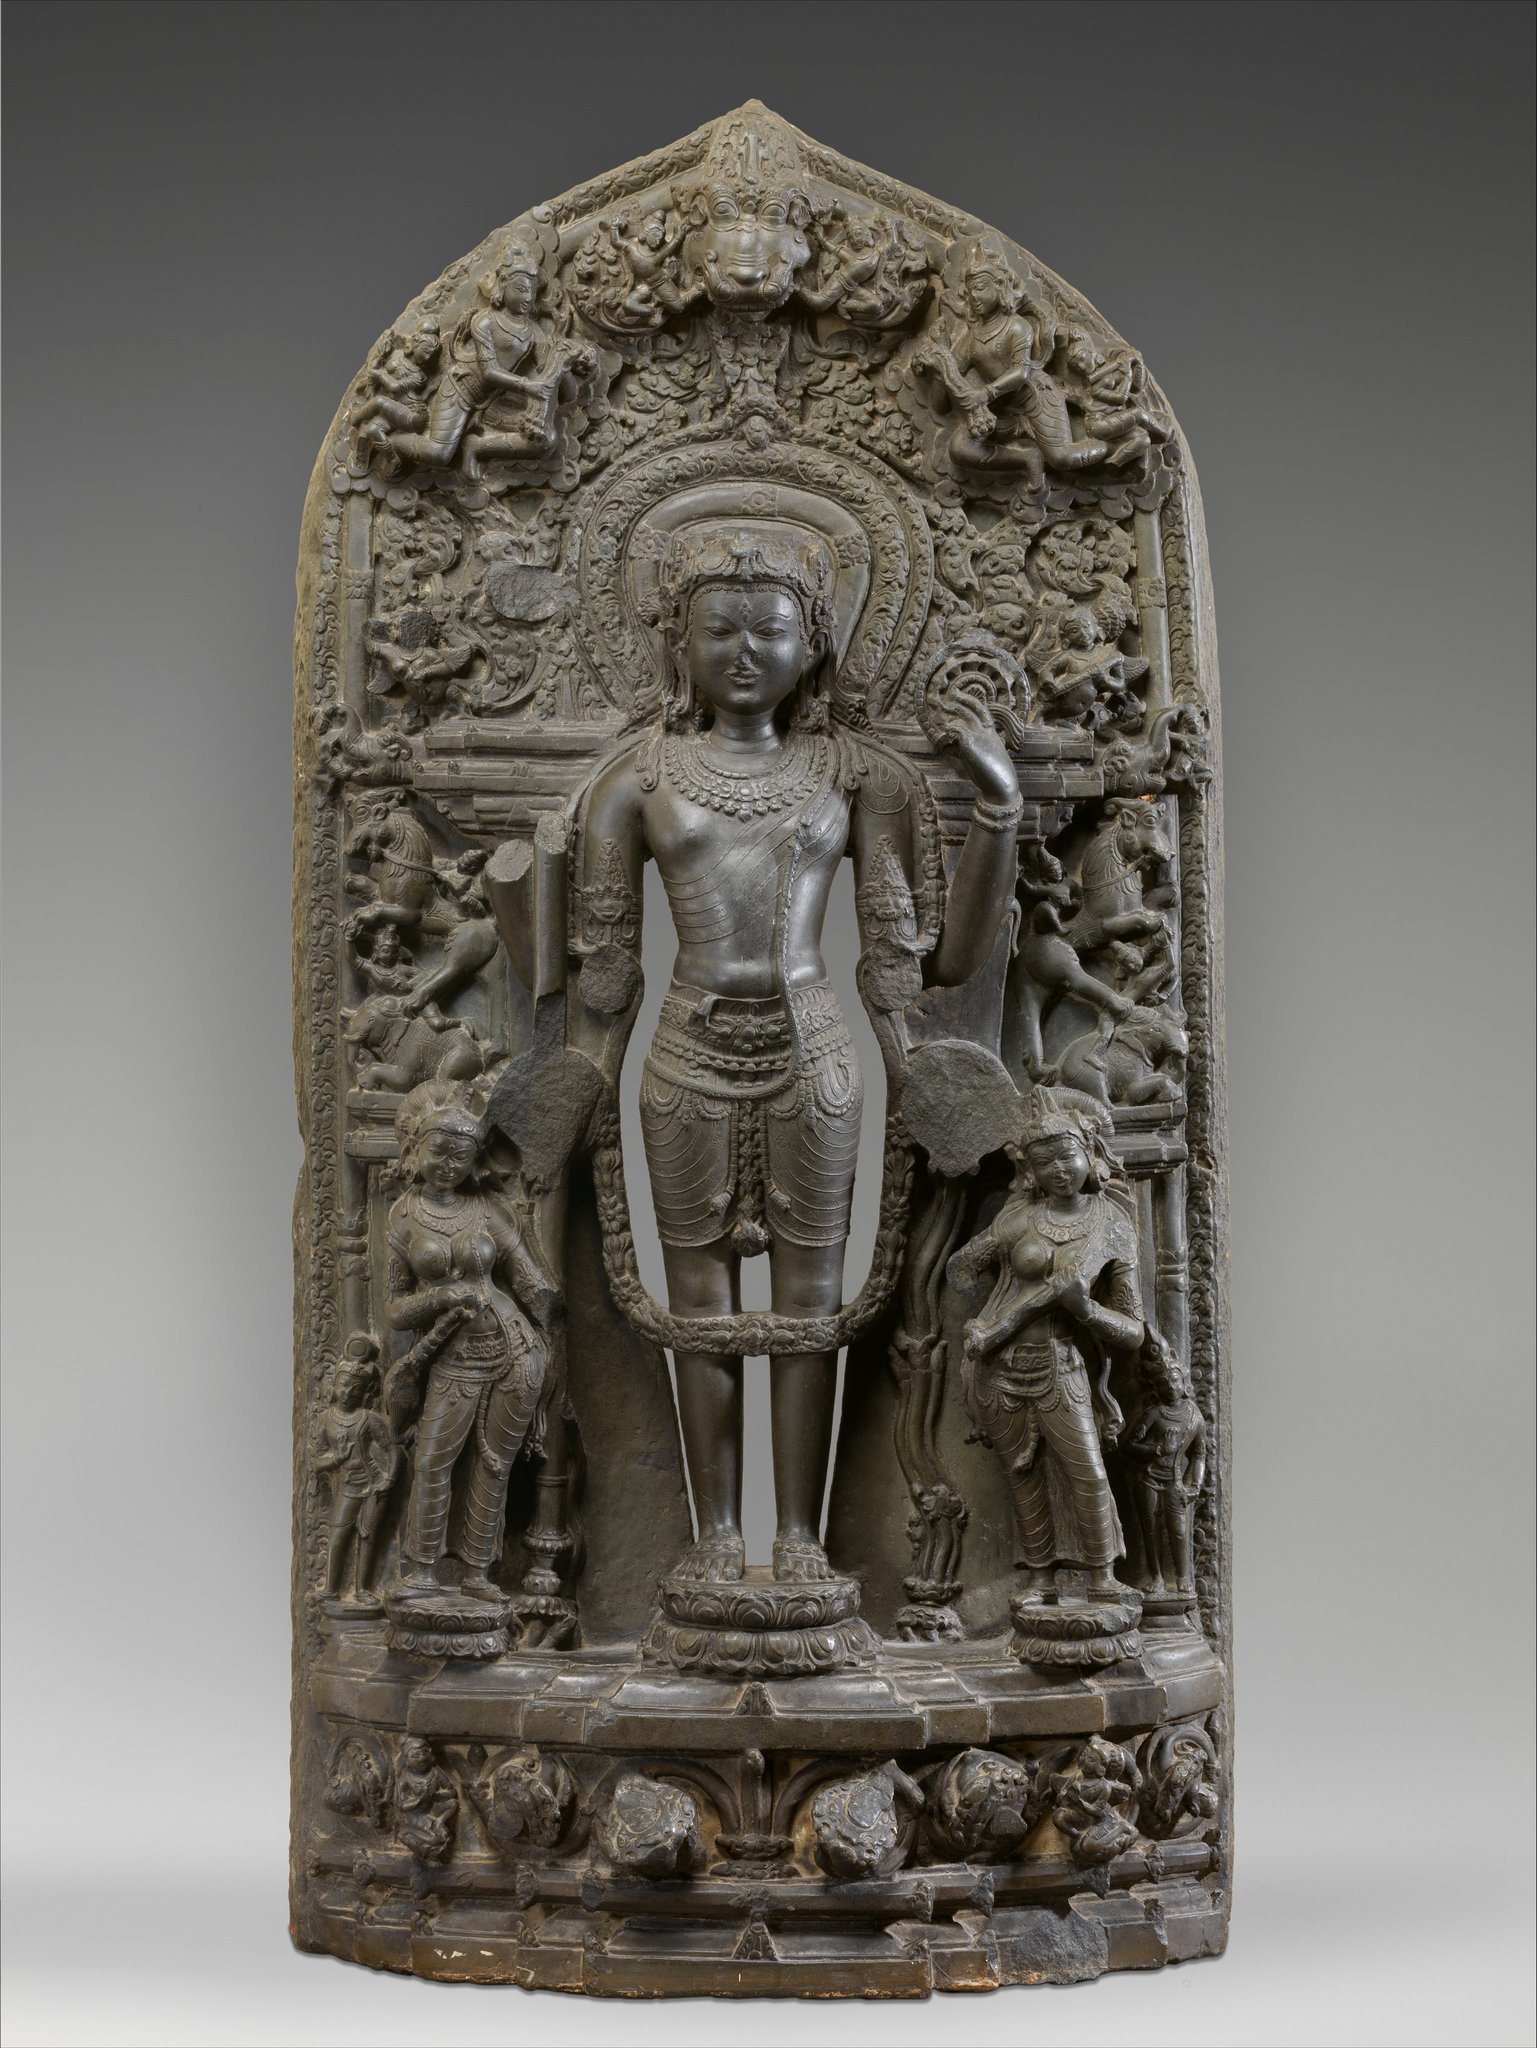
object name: stele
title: Vishnu Accompanied by Lakshmi and Sarasvati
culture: bangladeshi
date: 1101-1200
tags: vishnu,hinduism